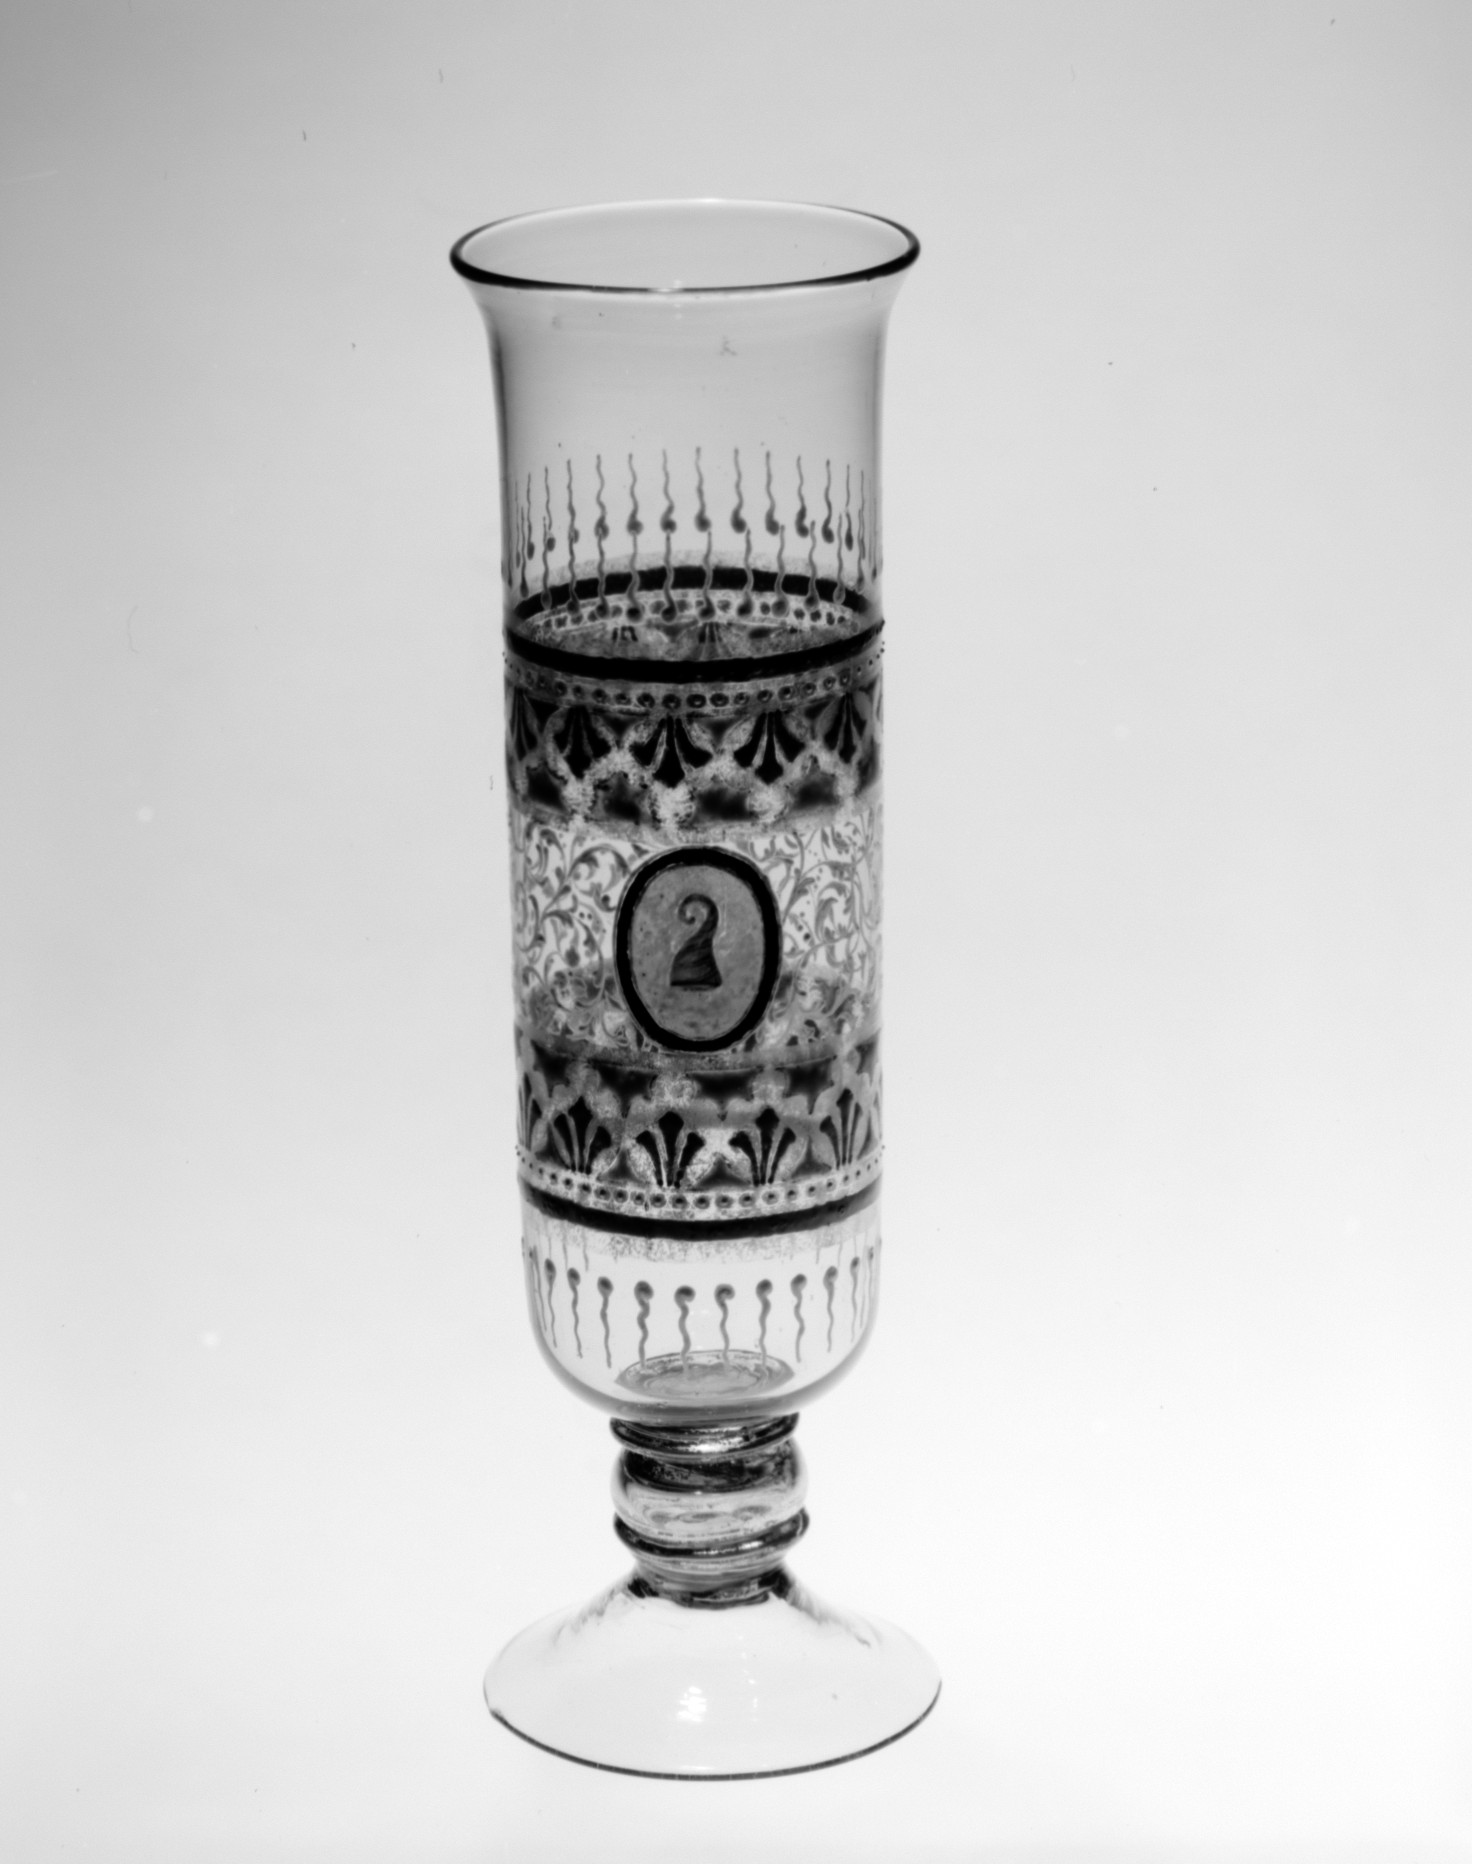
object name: lamp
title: Lamp (Cesendello)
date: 1801-1900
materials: gilt, glass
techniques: enamel